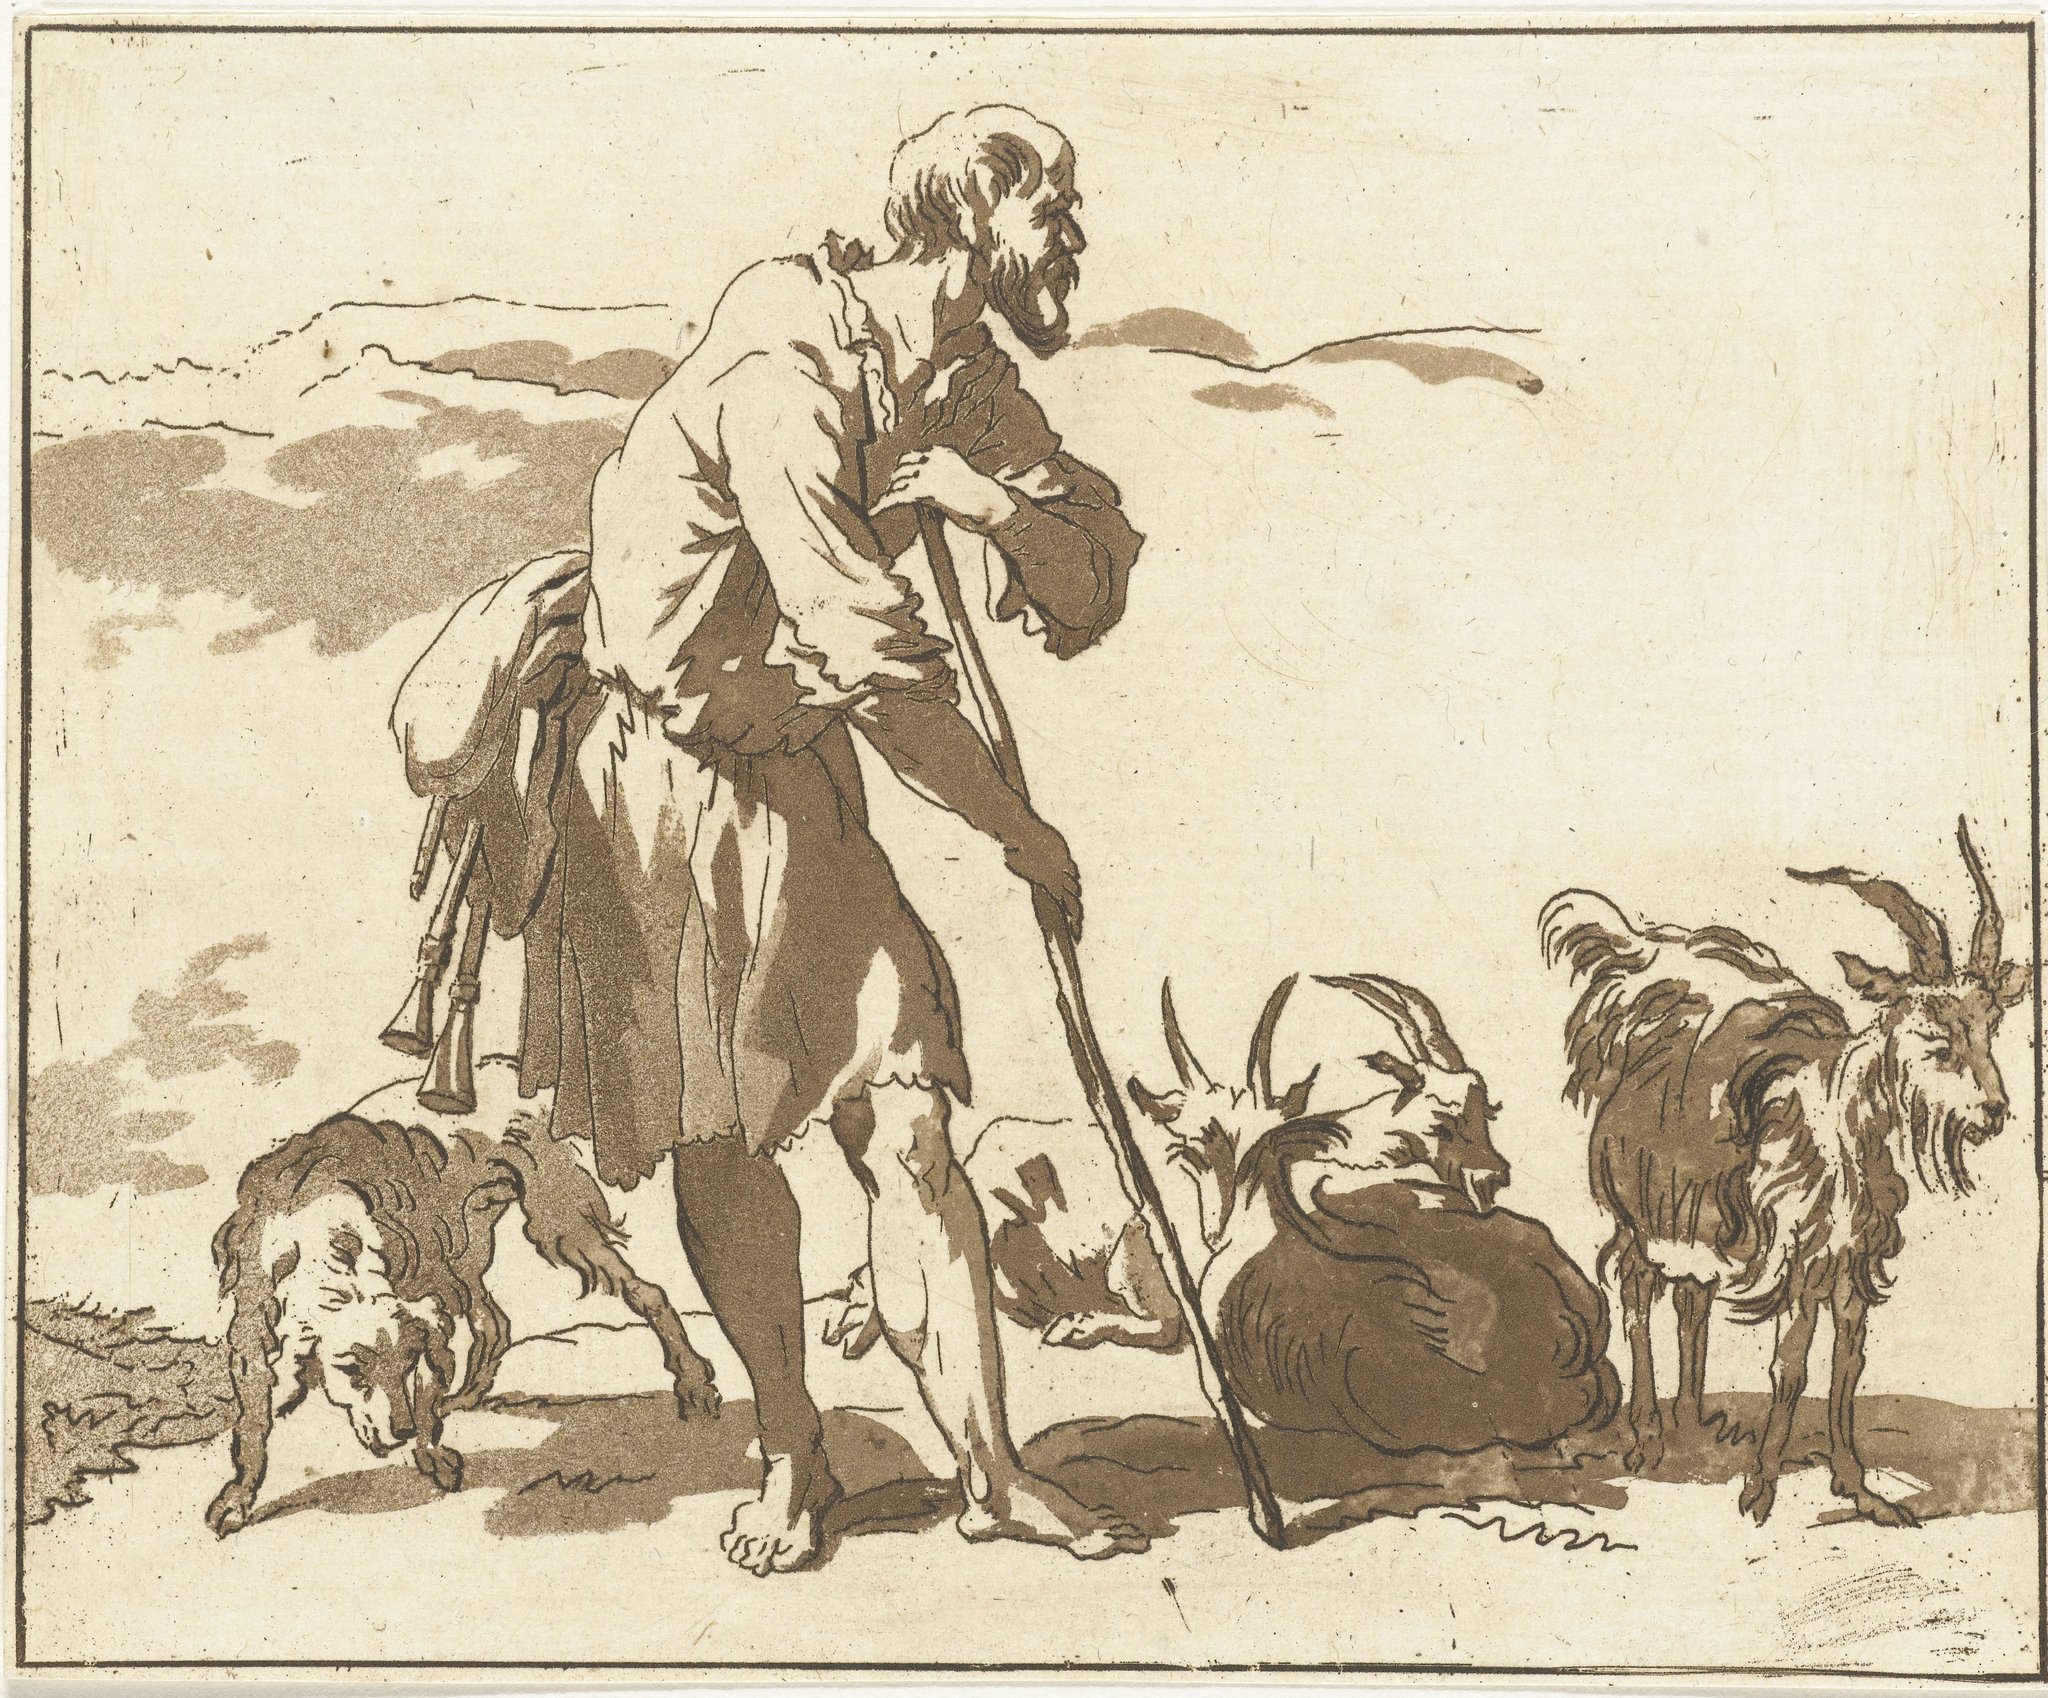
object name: print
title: Herder met geiten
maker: anthonie van den bos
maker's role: draughtsman, print maker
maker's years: 1763-1838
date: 1778-1838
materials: paper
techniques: aquatint, etching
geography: netherlands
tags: herding, herdsman, herdswoman, shepherd, shepherdess, cowherd, etc., bagpipe, musette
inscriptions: collector's mark: Lugt 2228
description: Herder leunend op een stok, met drie geiten en een herdershond. Op zijn rug draagt de herder een doedelzak.